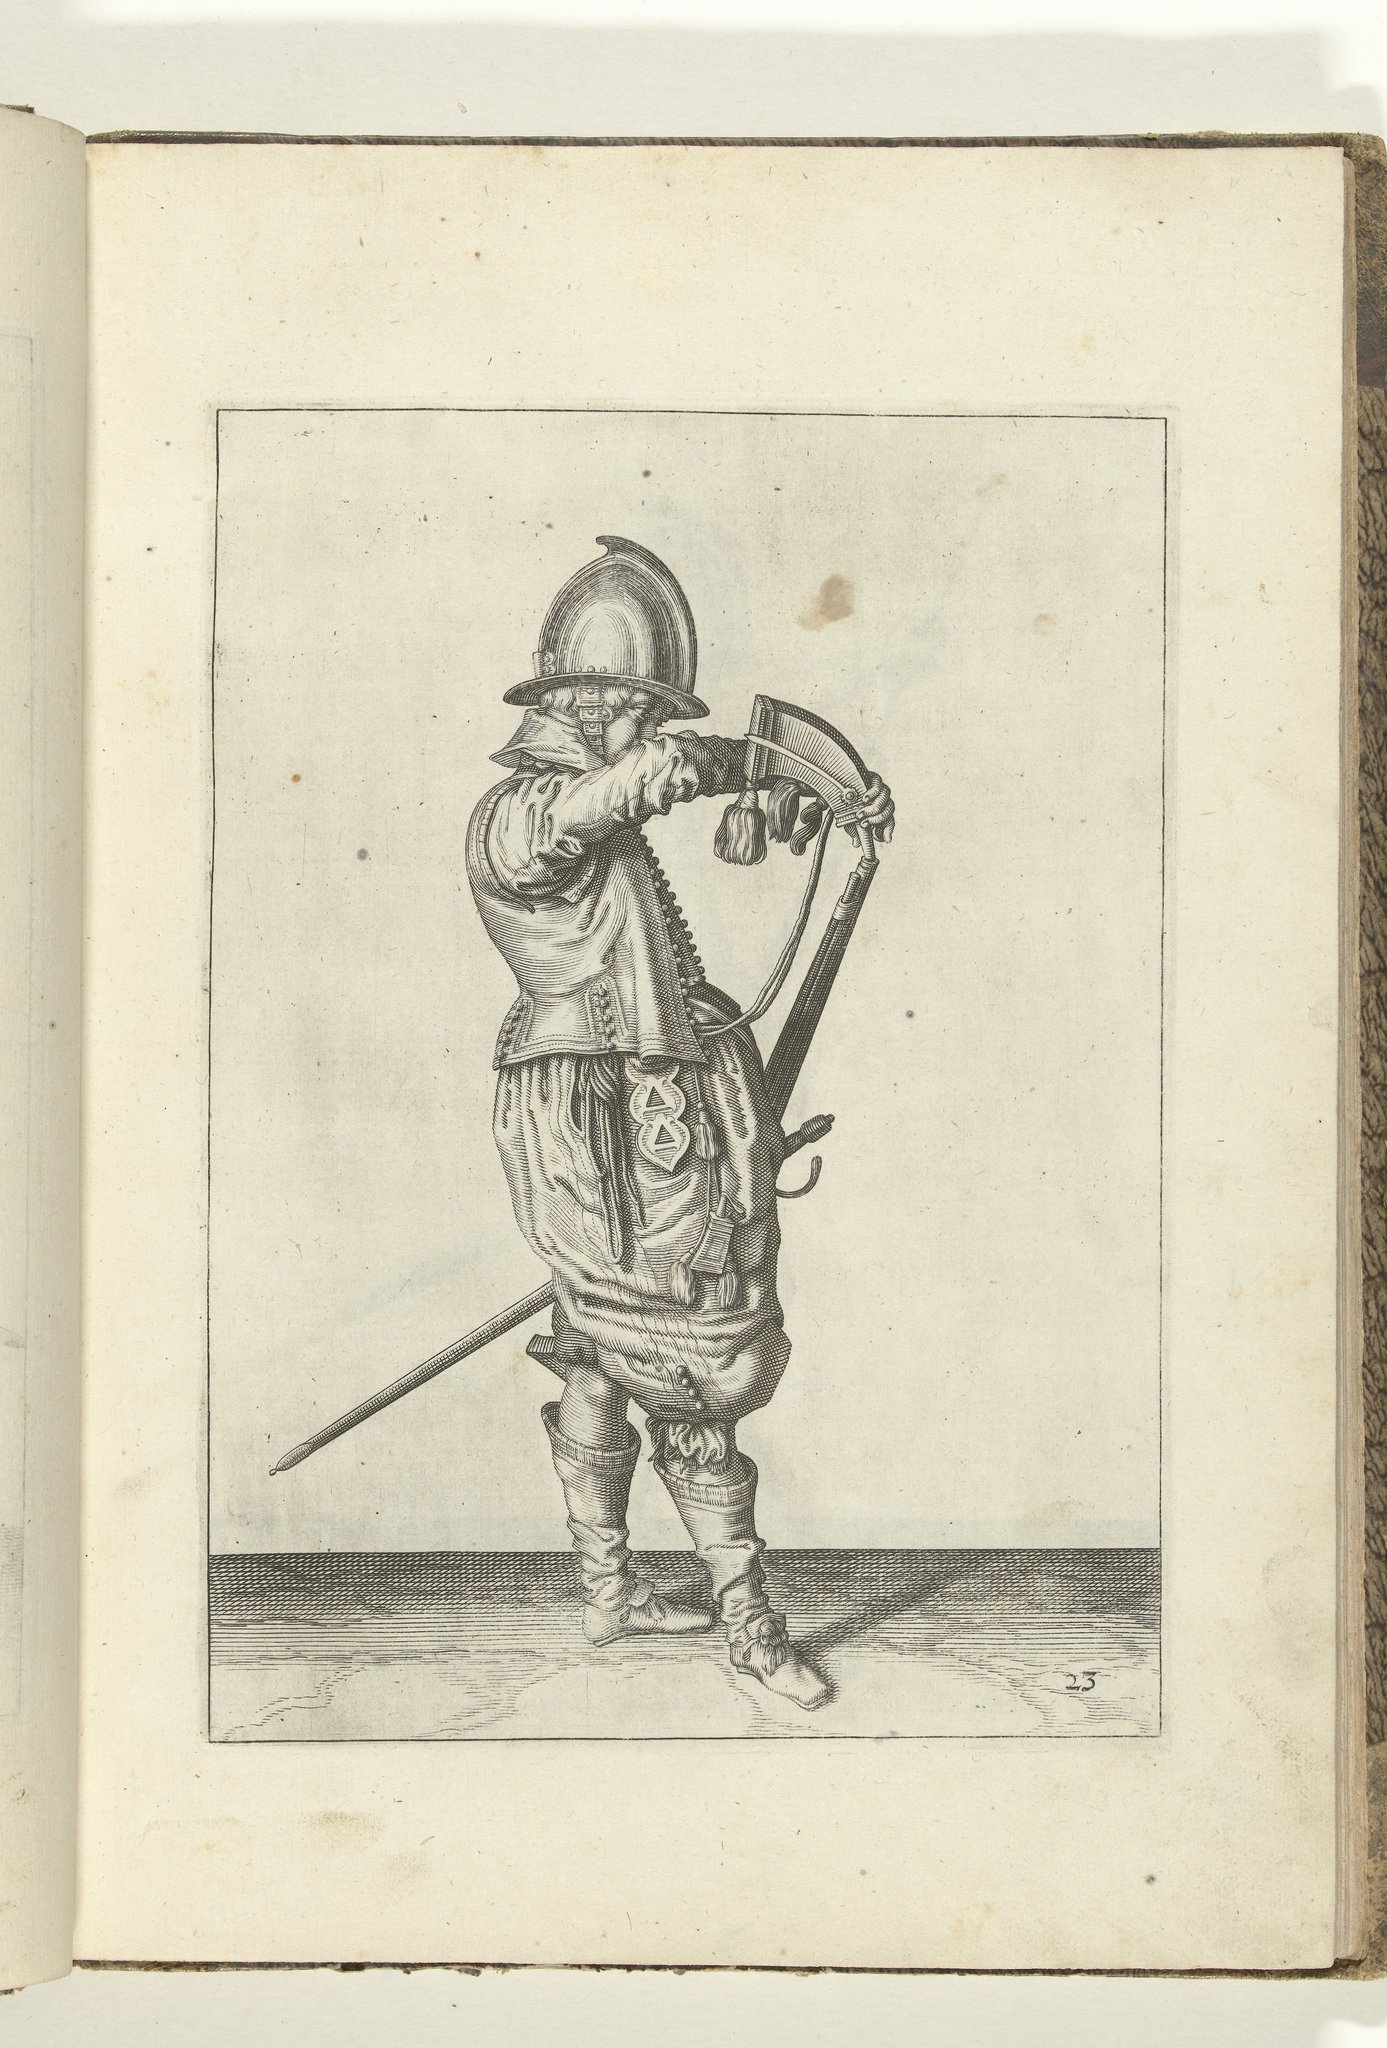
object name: print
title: Soldaat die kruit in de loop van zijn roer giet (nr. 23), ca. 1600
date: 1597-1608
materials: paper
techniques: engraving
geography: northern netherlands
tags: the hague, maurice (prince of orange), handling of weapons ~ military training, weapons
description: Een soldaat, ten voeten uit, naar rechts, die met zijn linkerhand bij zijn linkerdijbeen een roer (een bepaald type vuurwapen) vasthoudt, de loop schuin omhoog wijzend (nr. 23), ca. 1600. Met zijn rechterhand opent hij een kruithoorn. Plaat 23 in de instructies voor het hanteren van de roer: Brief enseignement, sur la representation des figures, du droit maniement de l'Harquebuse. Onderdeel van de illustraties in een Franse editie van J. de Gheyns Wapenhandelinghe: J. de Gheyn, Maniement d'armes, d'arquebuses, mousquetz et piques : en conformité de l'ordre de Mour le Prince Maurice, Prince d'Orange, Amsterdam 1608. Krijgswezen rond 1600.